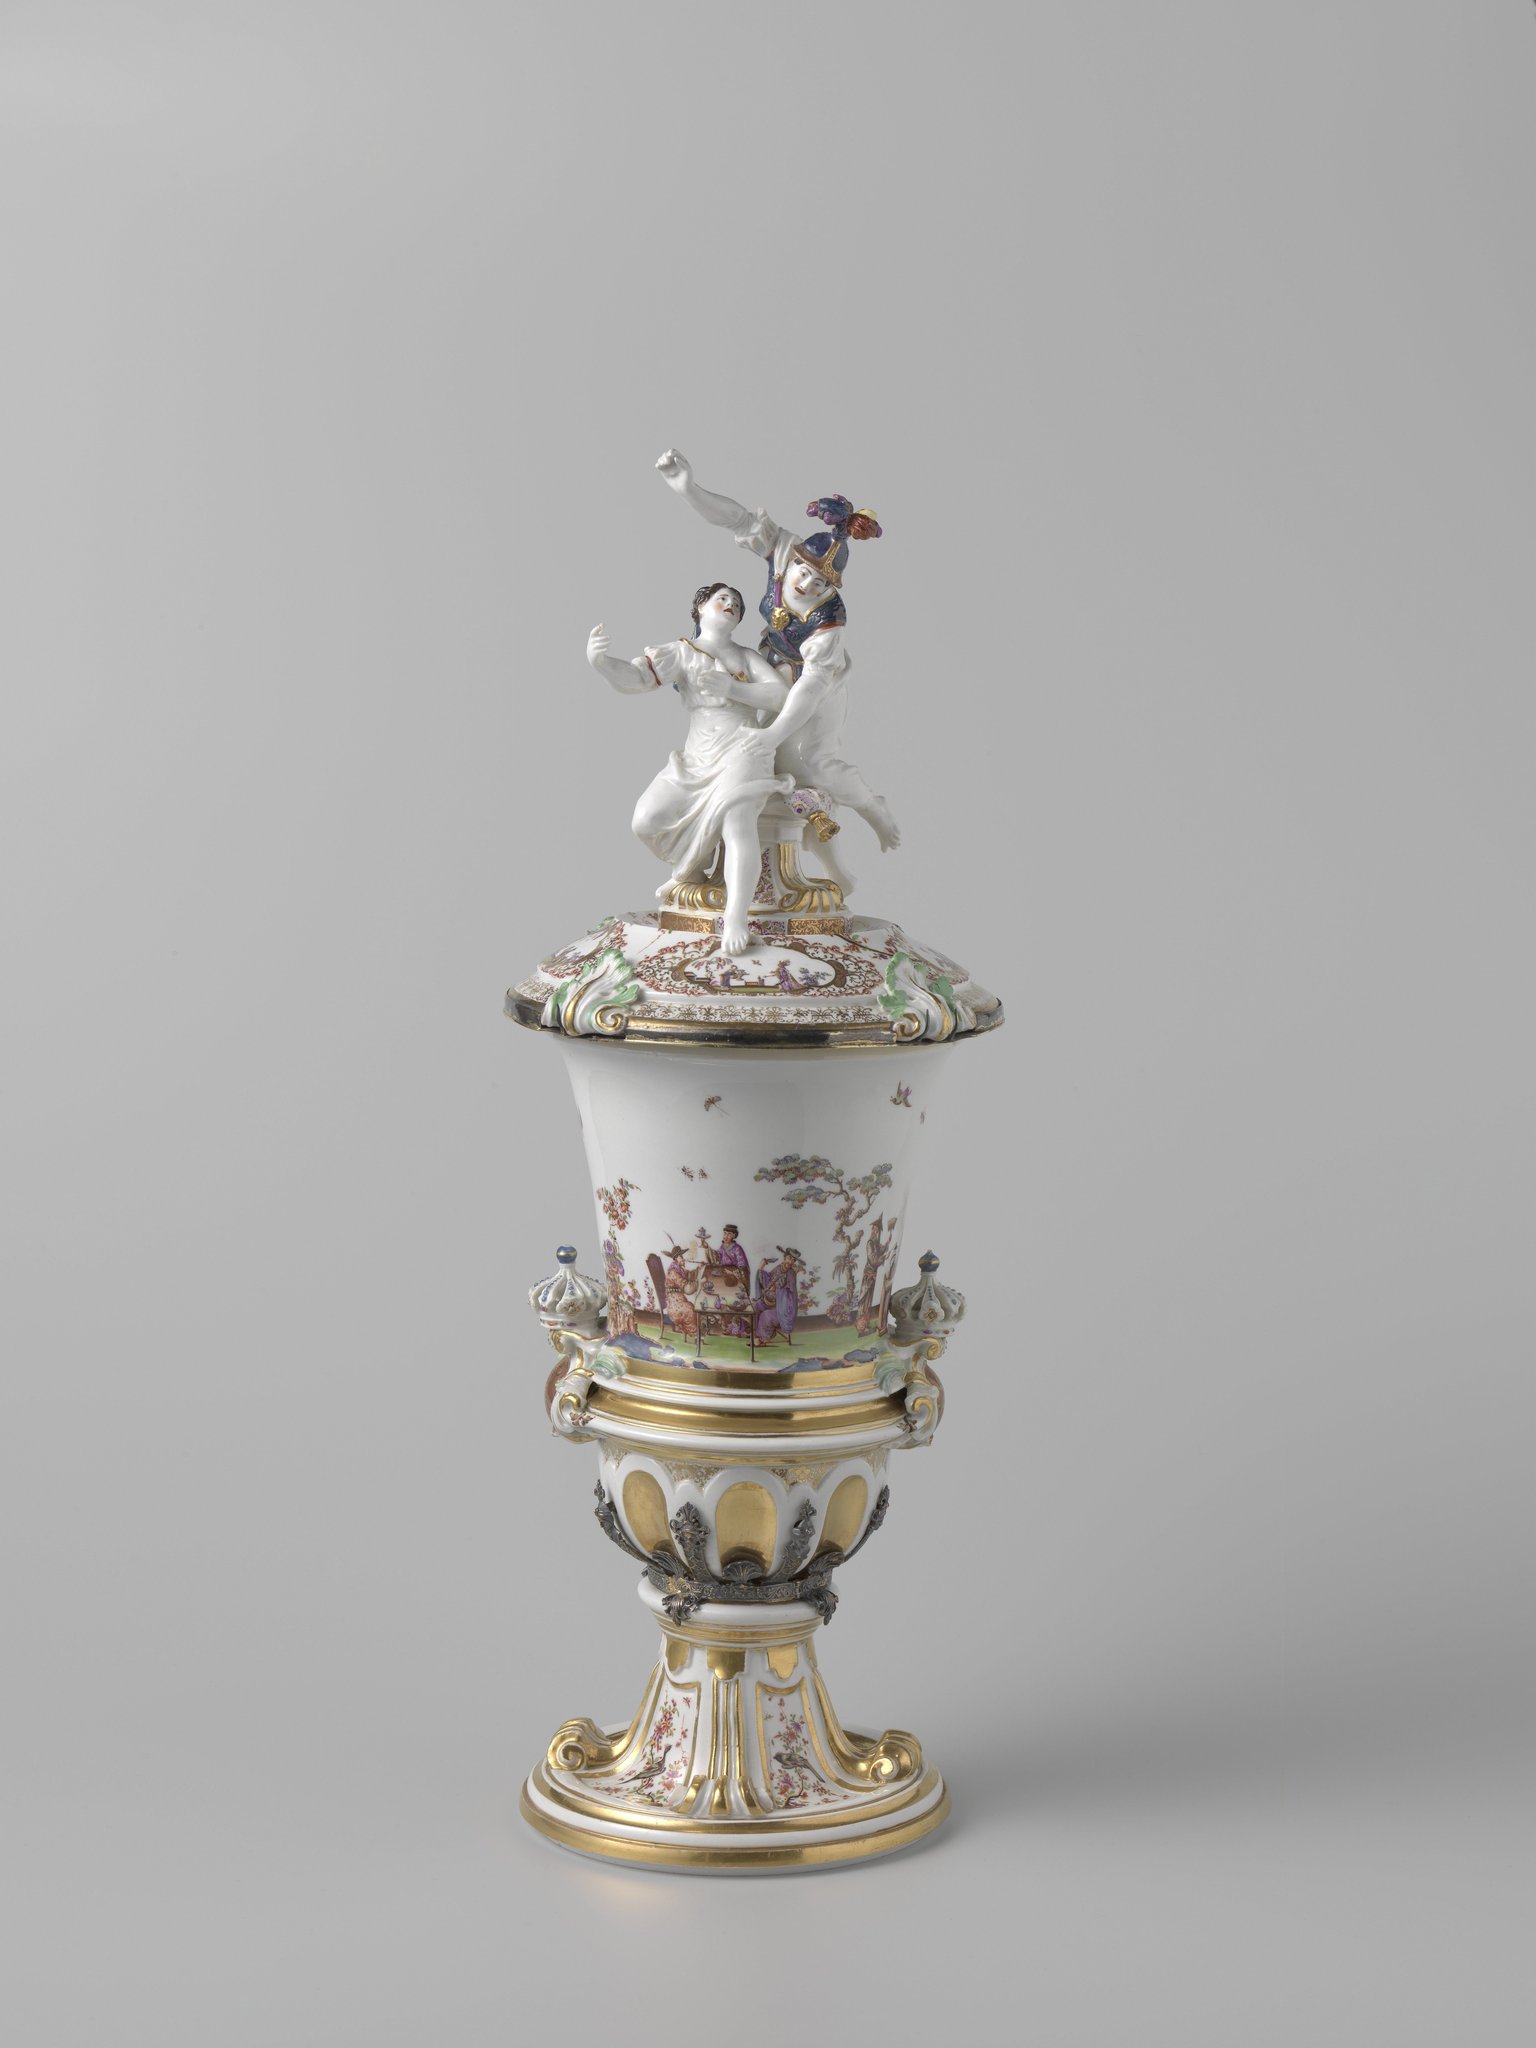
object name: goblet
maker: johann gottlieb kirchner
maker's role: ceramicist, sculptor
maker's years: 1706-1768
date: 1727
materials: porcelain, silver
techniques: gilding, painted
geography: meissen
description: Meissener Porzellan Manufaktur model attributed to Johann Gottlieb Kirchner (1706–after 1738) Meissen, c. 1727 hard-paste porcelain, silver gilt